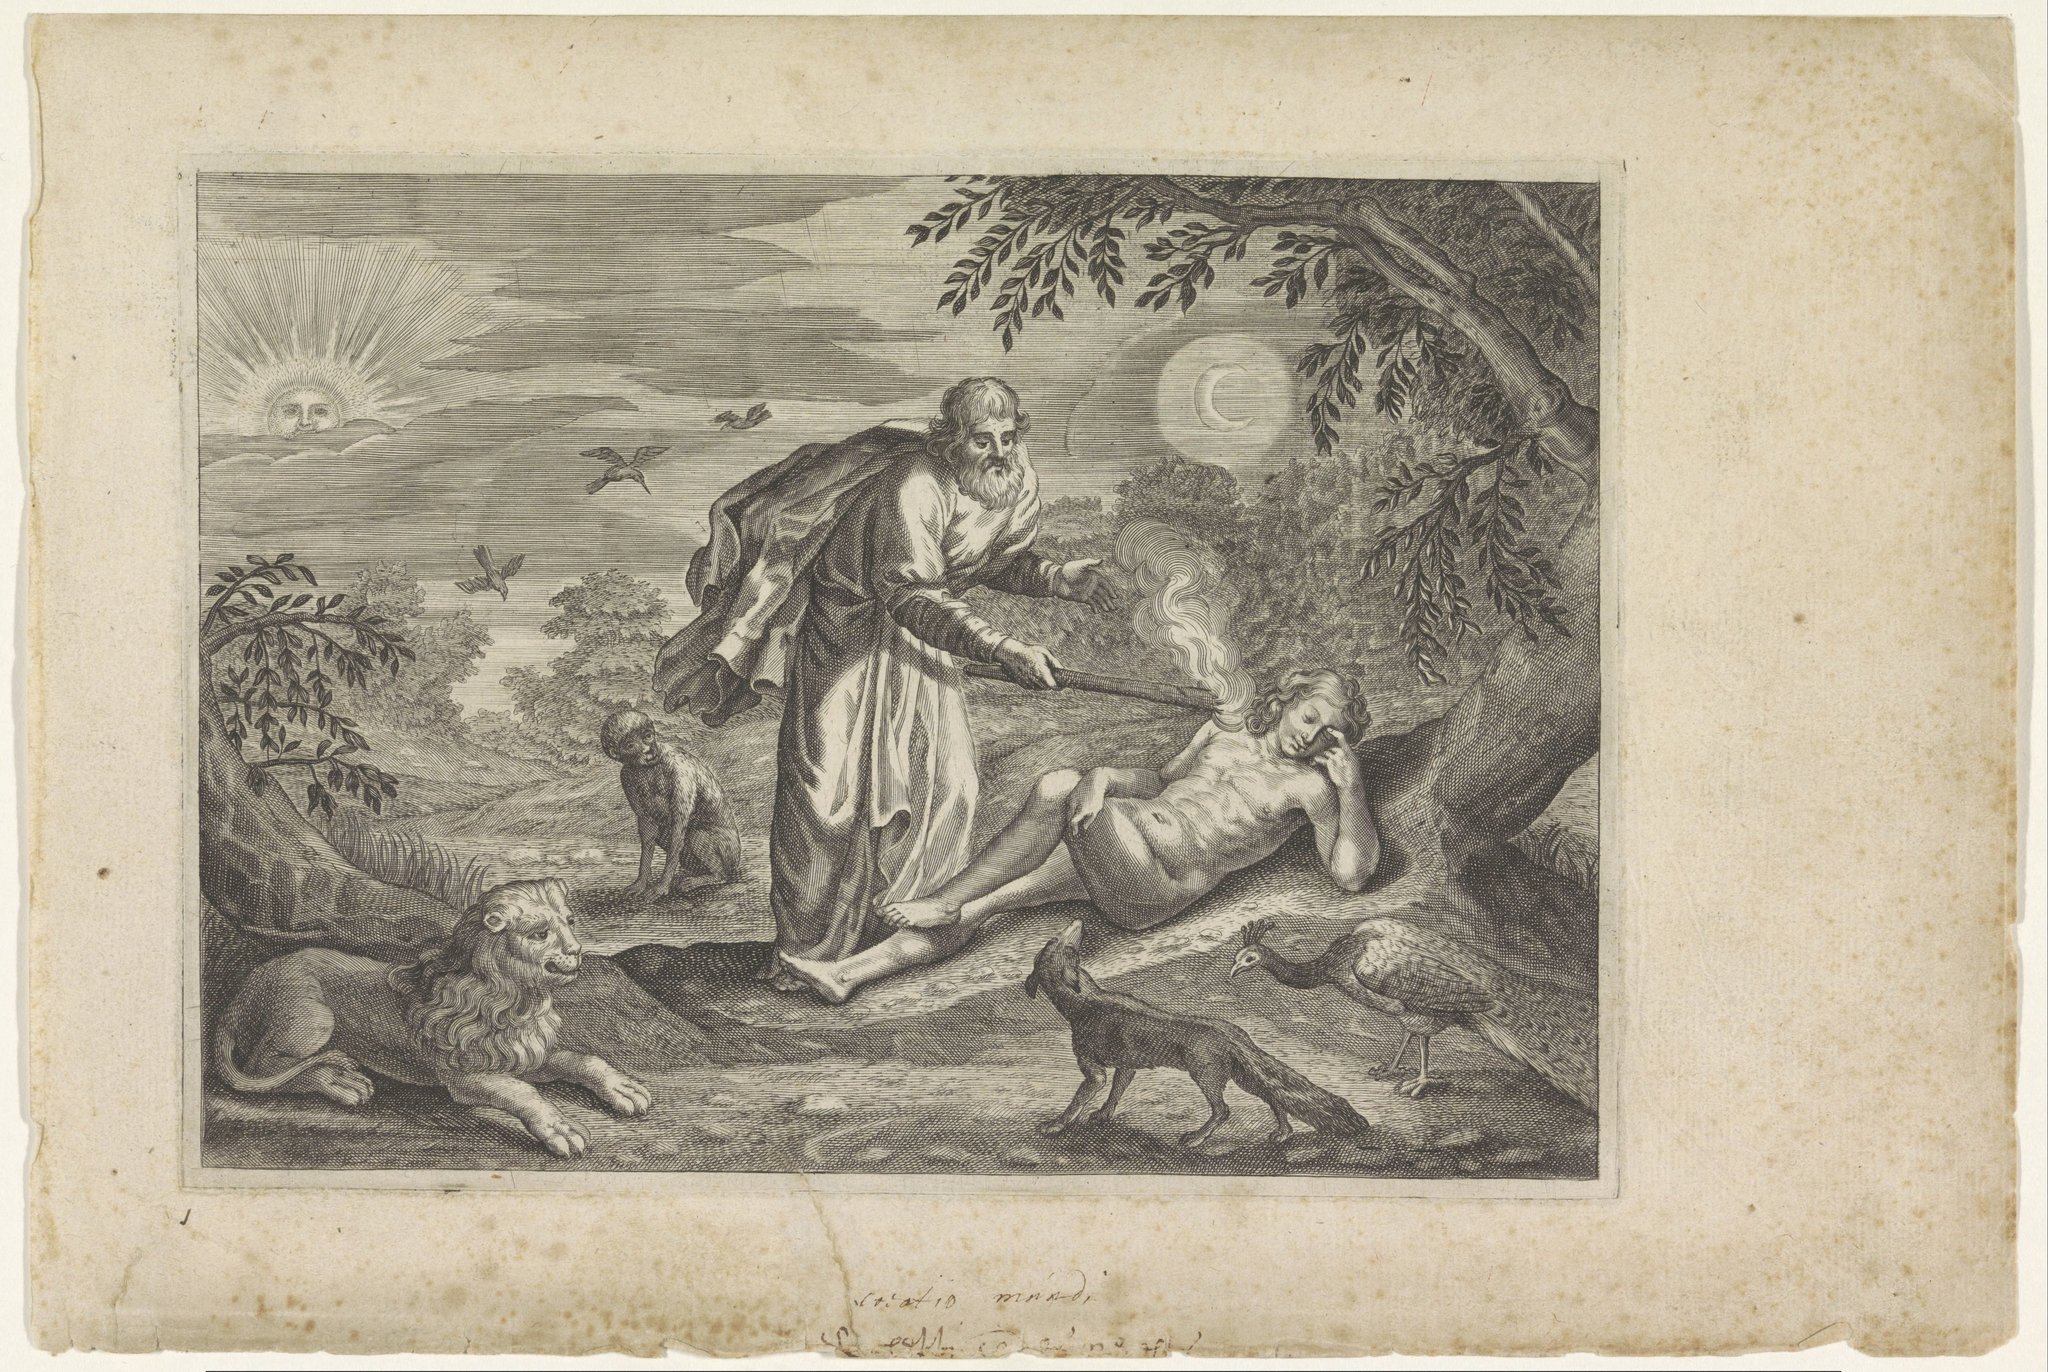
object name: print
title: Prometheus schept de eerste mens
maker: crispijn van de passe (ii)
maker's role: draughtsman, print maker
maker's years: 1594-1670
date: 1636-1670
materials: paper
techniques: engraving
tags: prometheus animates the man he has formed with the stolen fire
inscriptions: number: ‘1’, annotation: ‘creatio mundi/ [...]’, collector's mark: ‘Hinloopen’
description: Deze incomplete serie, bestaande uit 77 van de in totaal 85 prenten met scènes uit Ovidius' Metamorfosen, werd in 1709 samen met Ovidius-illustraties van Tempesta, Goltzius en Le Pautre in één album, Schijnvoet nummer 43, ingebonden. In de negentiende eeuw werd deze band weer uit elkaar gehaald.